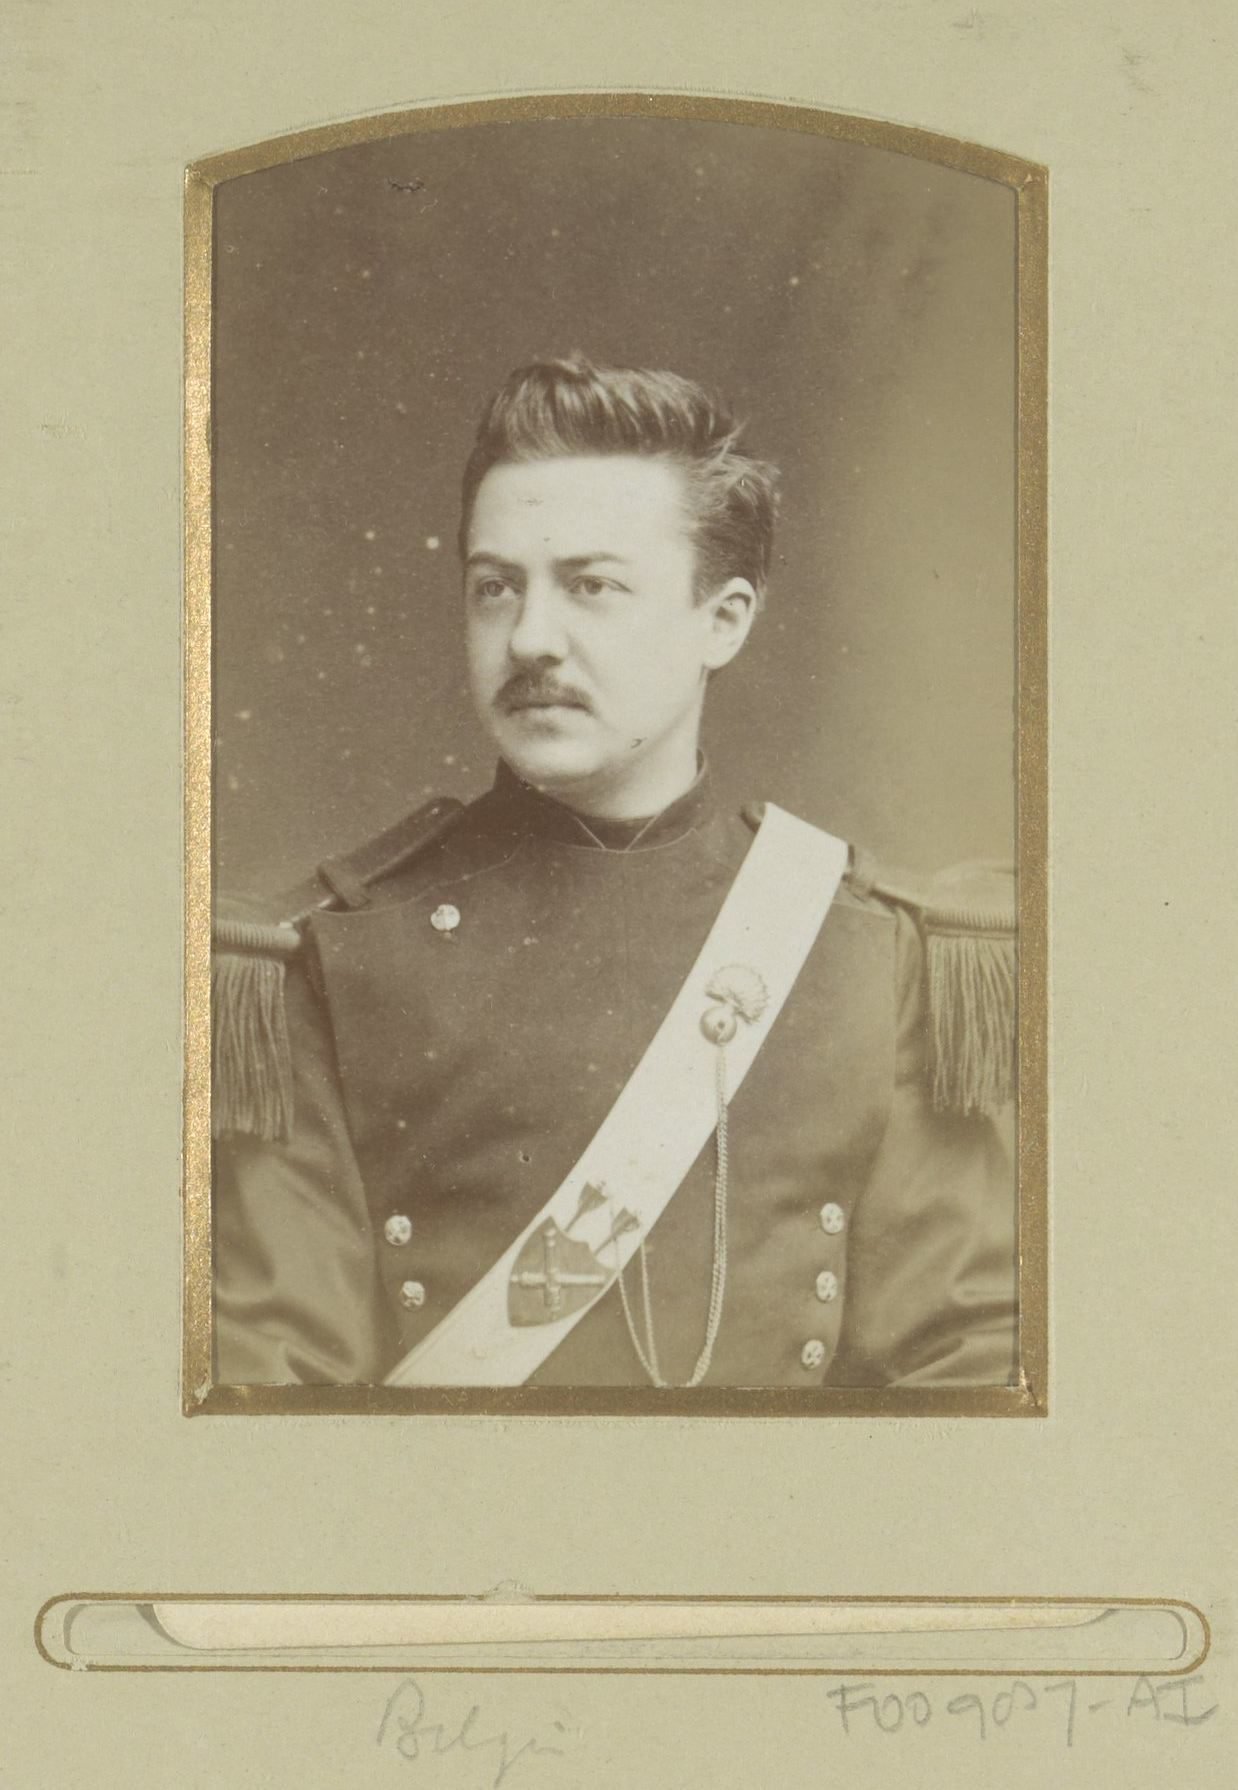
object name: carte de visite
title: Portret van Jean Dumont, Belgisch militair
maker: eugene guérin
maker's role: fotograaf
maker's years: 1845-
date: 1883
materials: cardboard, paper, photographic support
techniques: albumen print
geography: brussels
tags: warfare; military affairs, (military) uniforms, division of armed forces, brussels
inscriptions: address: ‘142, rue Royale 142’, inscription: ‘A Mlle. [...]osine Piret Souvenir d'amitié 4 octobre 1883’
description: Onderdeel van Album met cartes-de-visite en kabinetfoto's van militairen in uniform.